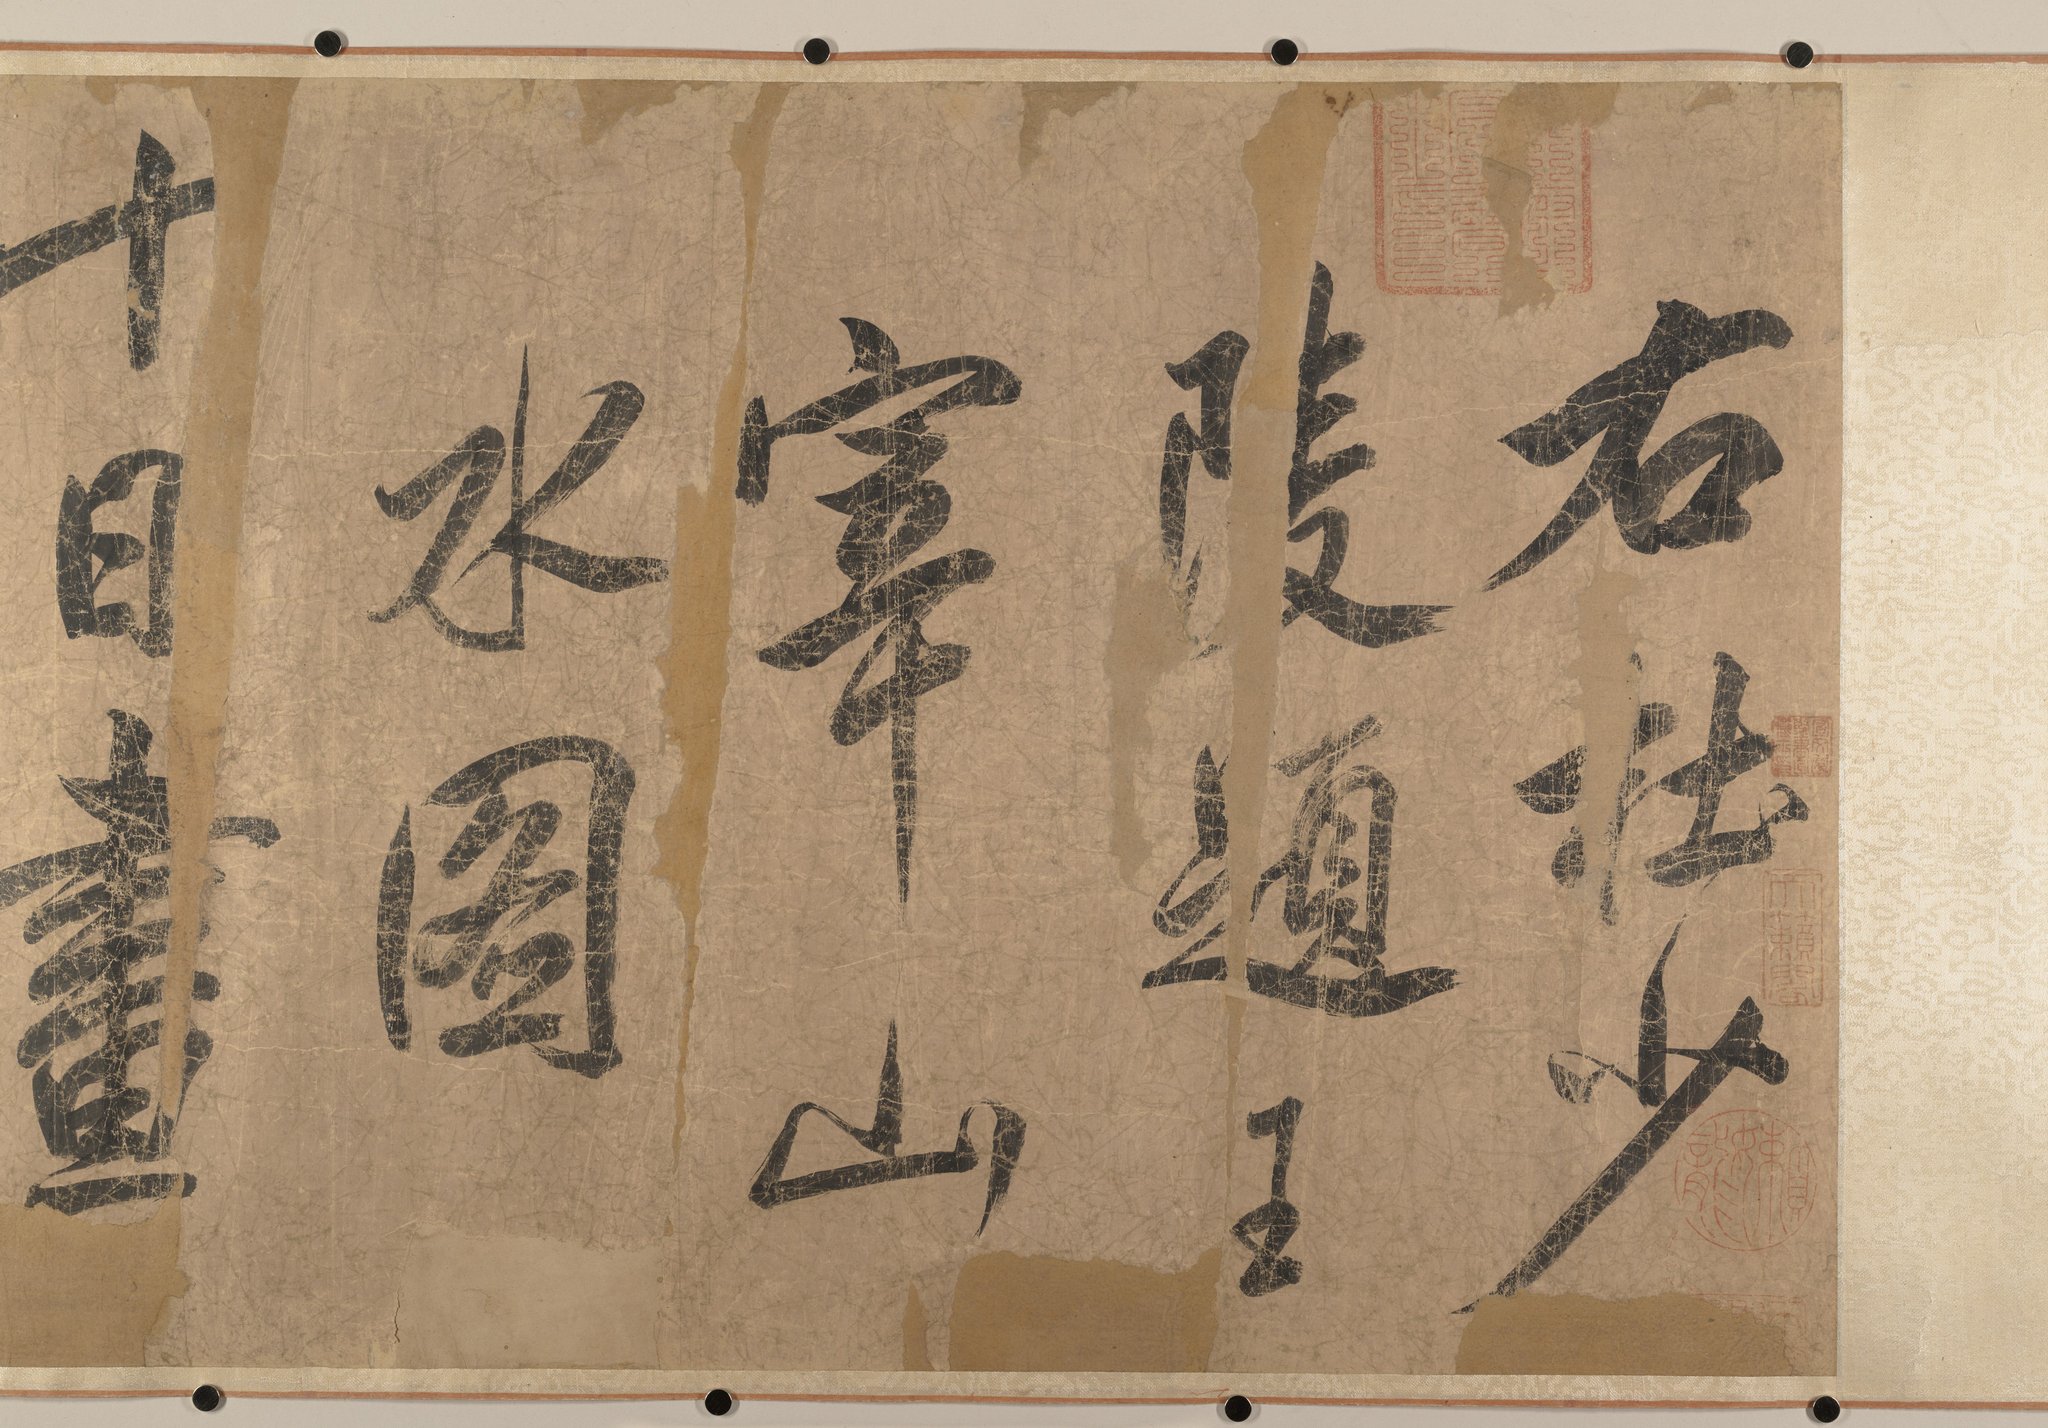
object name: handscroll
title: Treatise on Painting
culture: chinese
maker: unidentified artist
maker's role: artist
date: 960-1300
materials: ink, silk